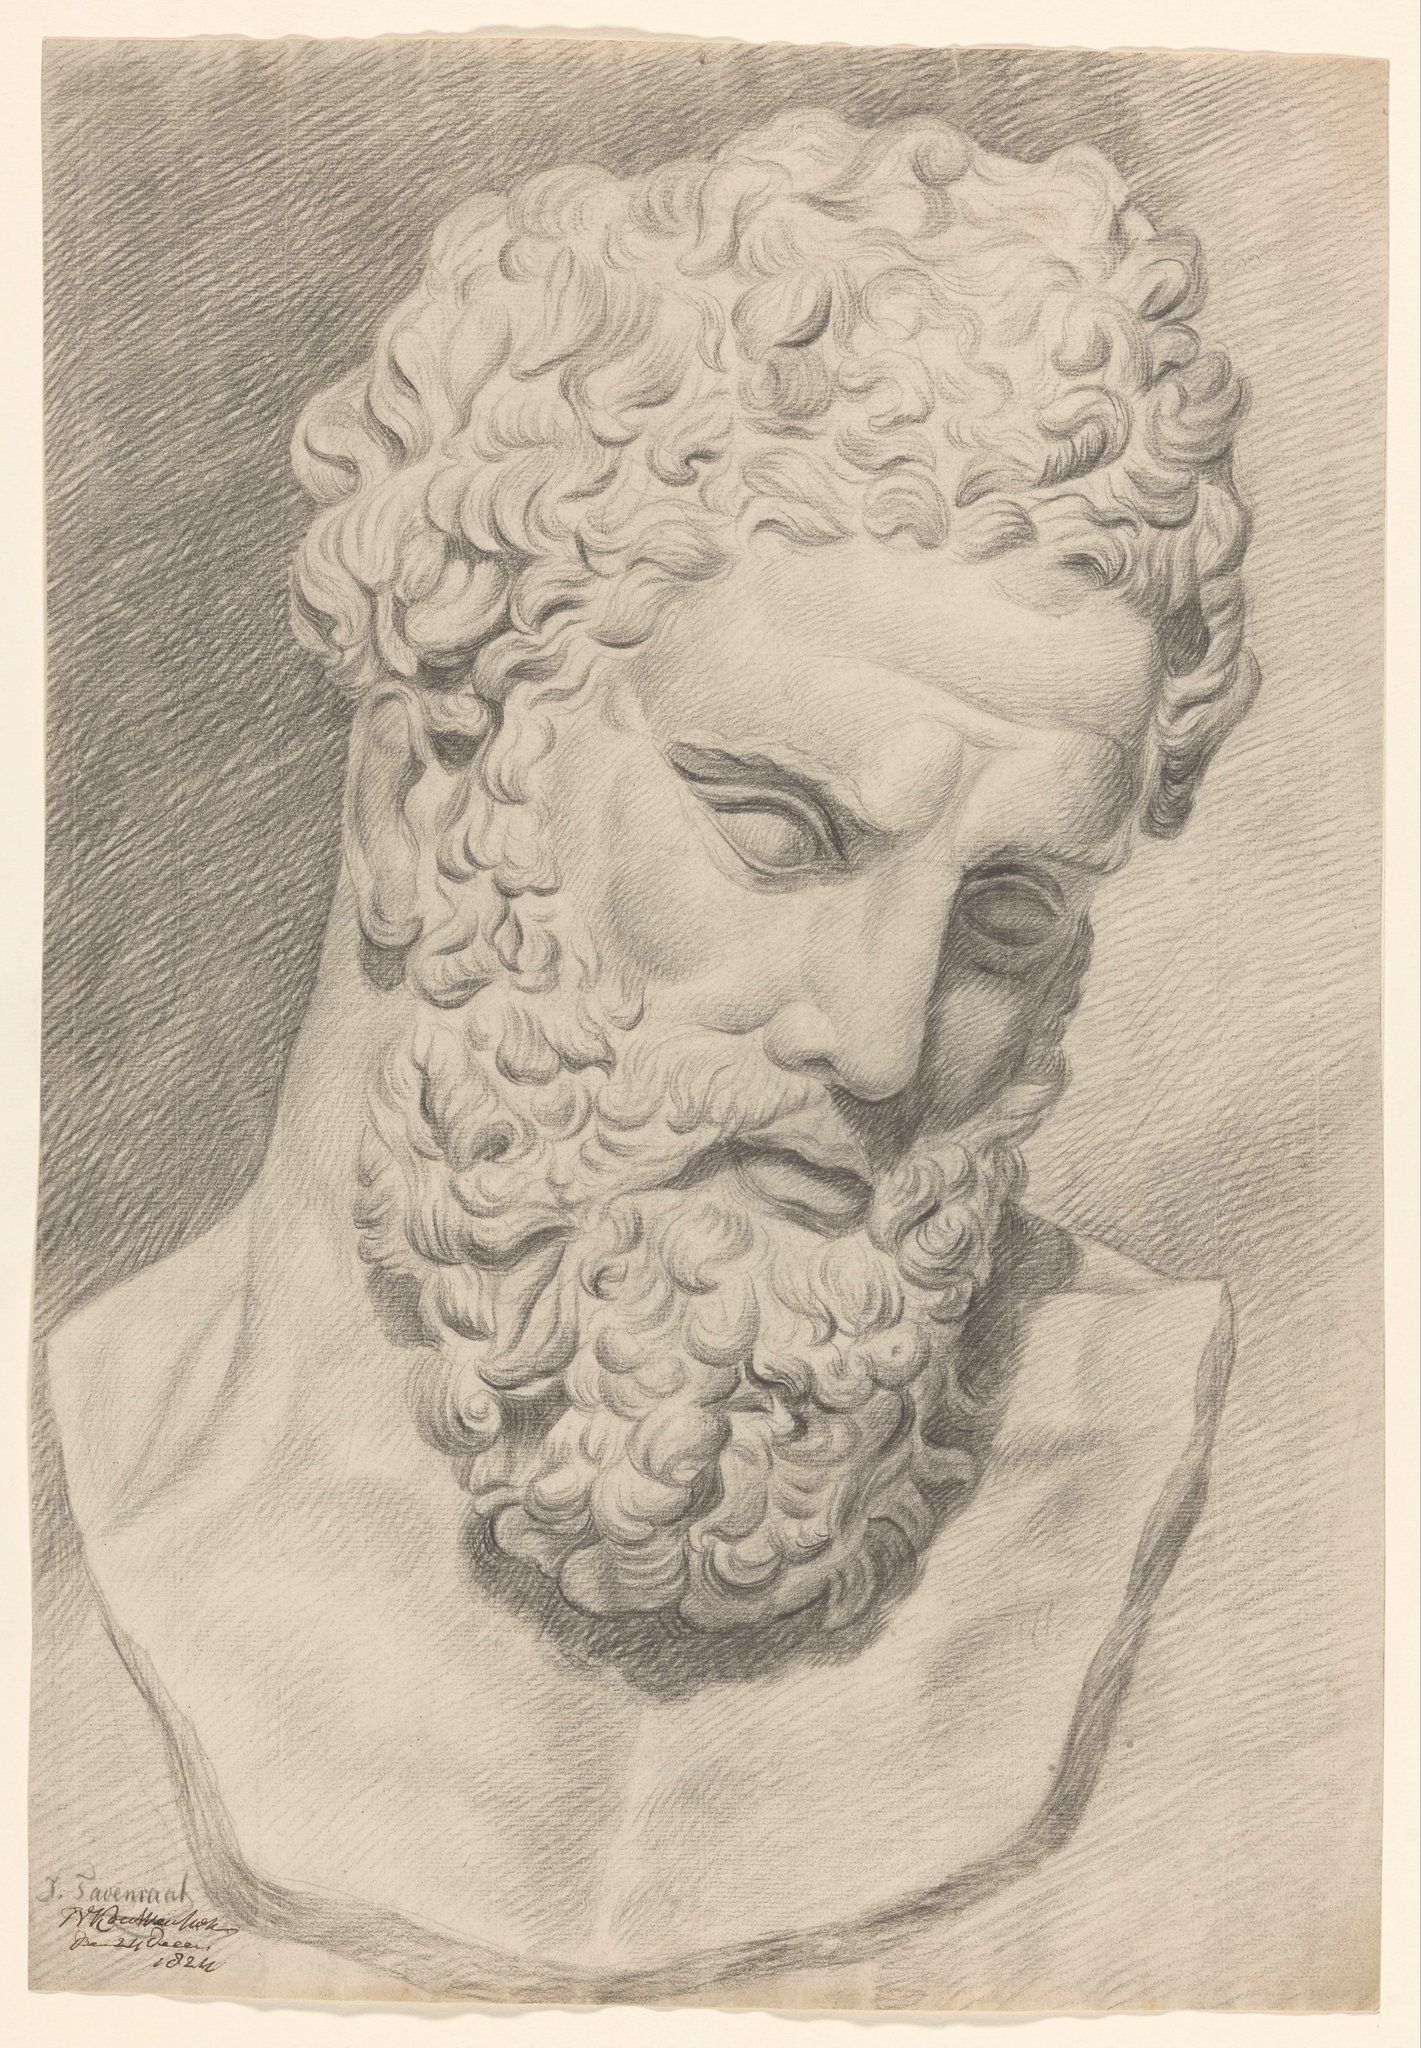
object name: drawing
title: Academiestudie: gipsbeeld van man met baard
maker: johannes tavenraat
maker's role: draughtsman, painter, print maker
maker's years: 1809-1881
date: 1824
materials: chalk, paper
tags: piece of sculpture, reproduction of a piece of sculpture (+ ceramics ~ arts)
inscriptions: date